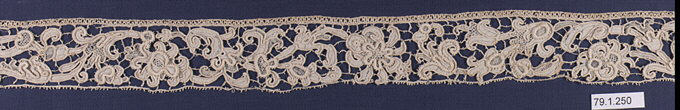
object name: strip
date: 1601-1700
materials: lace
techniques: gros point, lace